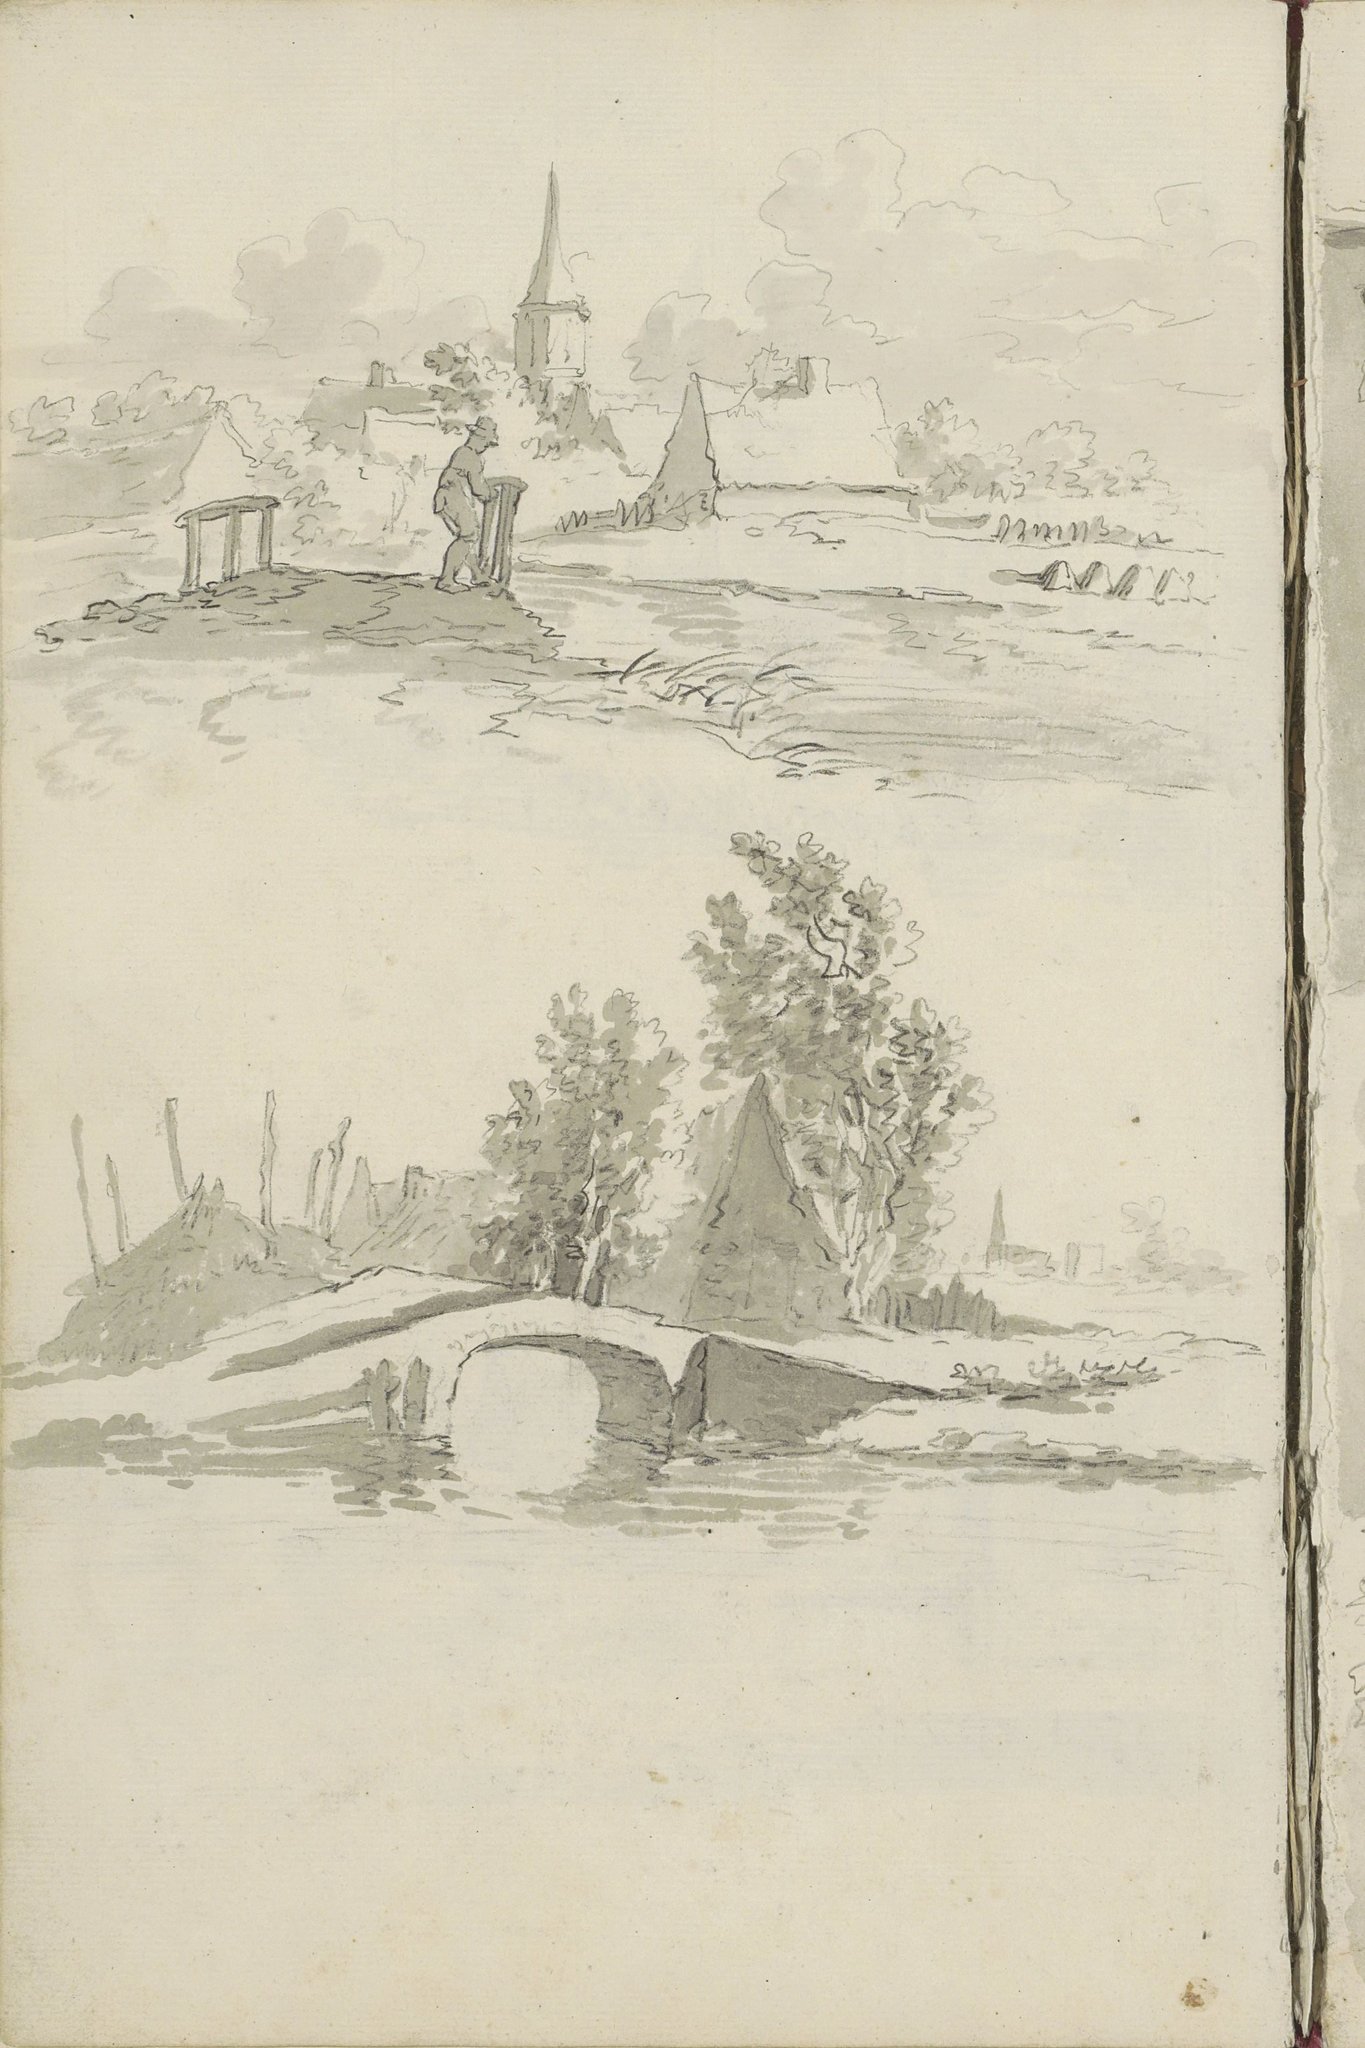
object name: sketchbook leaf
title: Dorpsgezicht met kerktoren en een brug over het water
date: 1780-1800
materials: paper, pencil, watercolor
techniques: brush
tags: prospect of village, silhouette of village, landscapes with waters, waterscapes, seascapes (in the temperate zone), bridge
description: Blad 21 verso uit een schetsboek met 25 bladen.